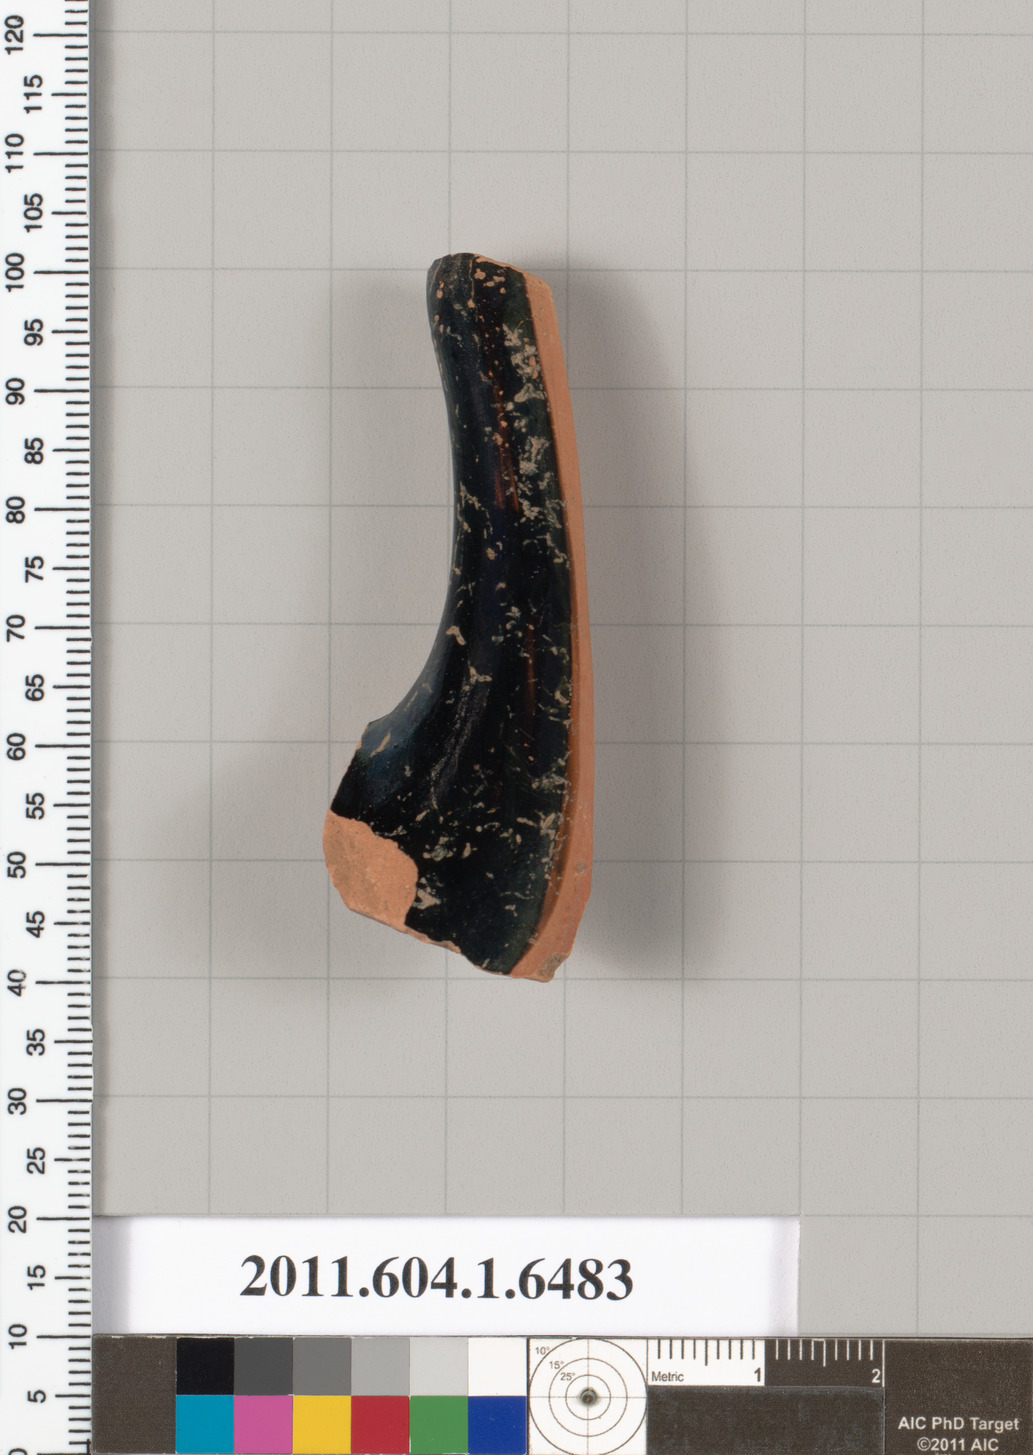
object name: kylix fragment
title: Terracotta fragment of a kylix (drinking cup)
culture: greek, attic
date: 490-480 BCE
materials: terracotta